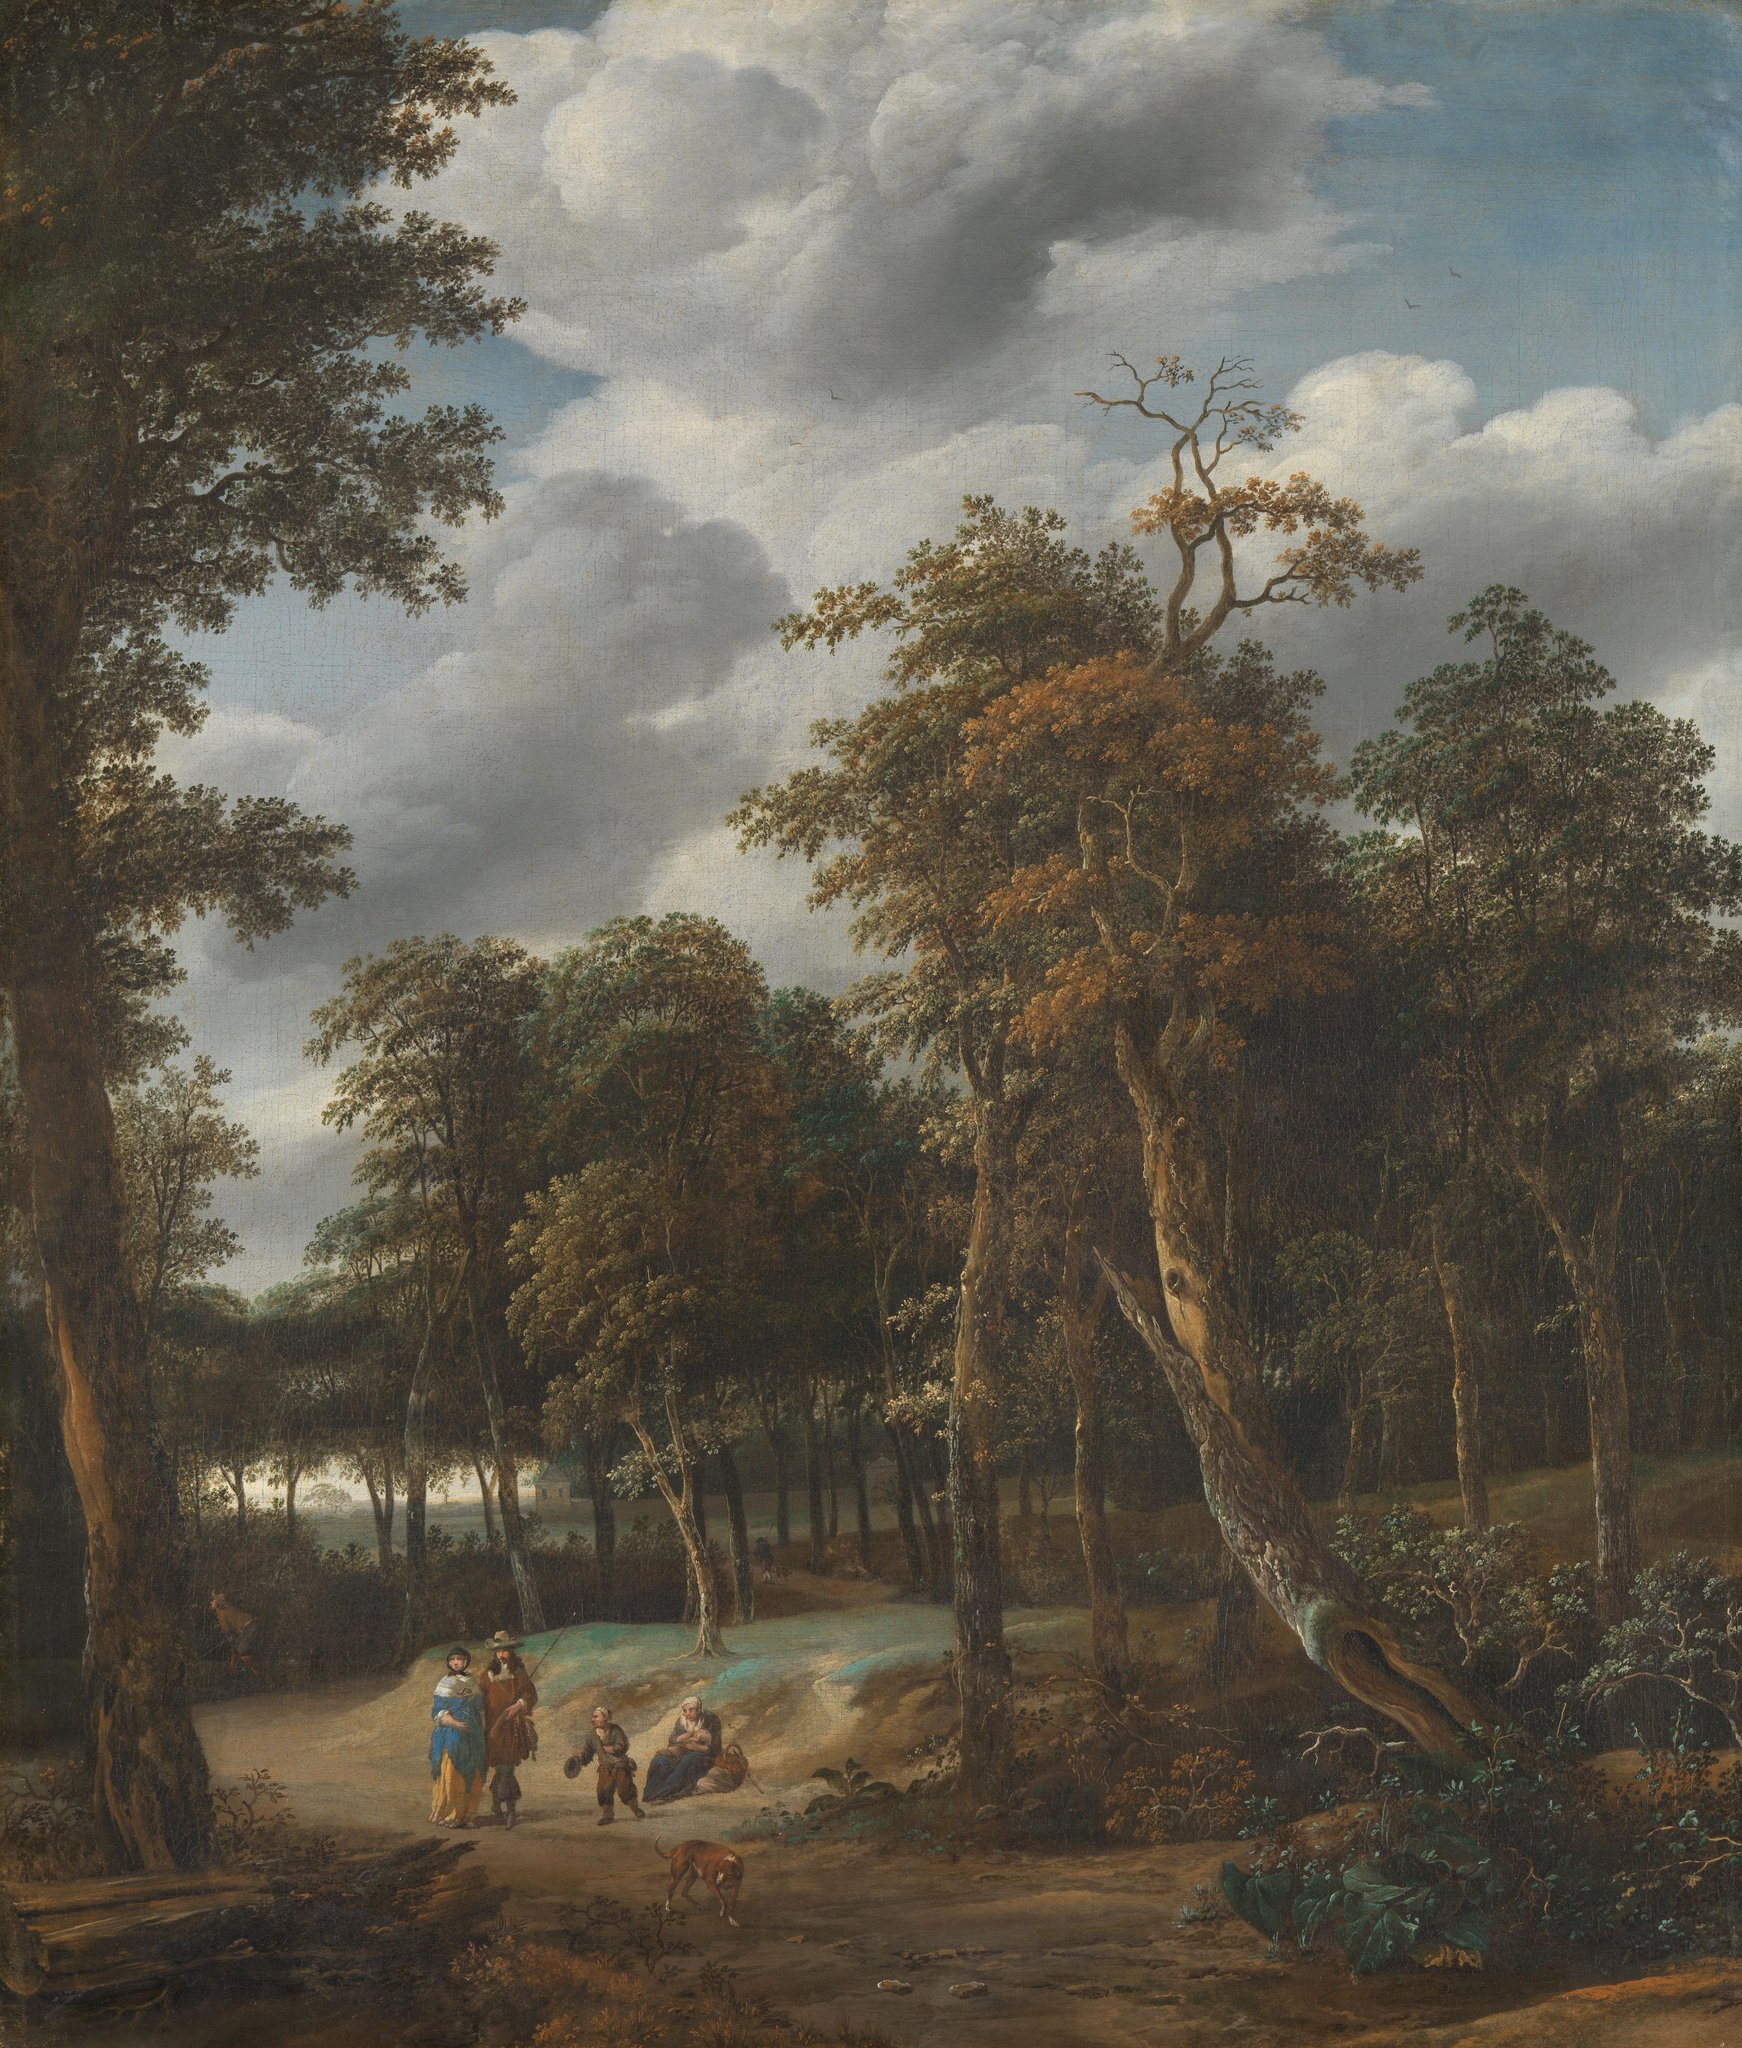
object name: painting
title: Forest Road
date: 1650-1674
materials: canvas, oil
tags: forest path or lane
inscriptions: signature: ‘J. Loote’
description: Boslandschap met enkele figuren bij een weg. Een jongetje spreekt een wandelend elegant paar aan.